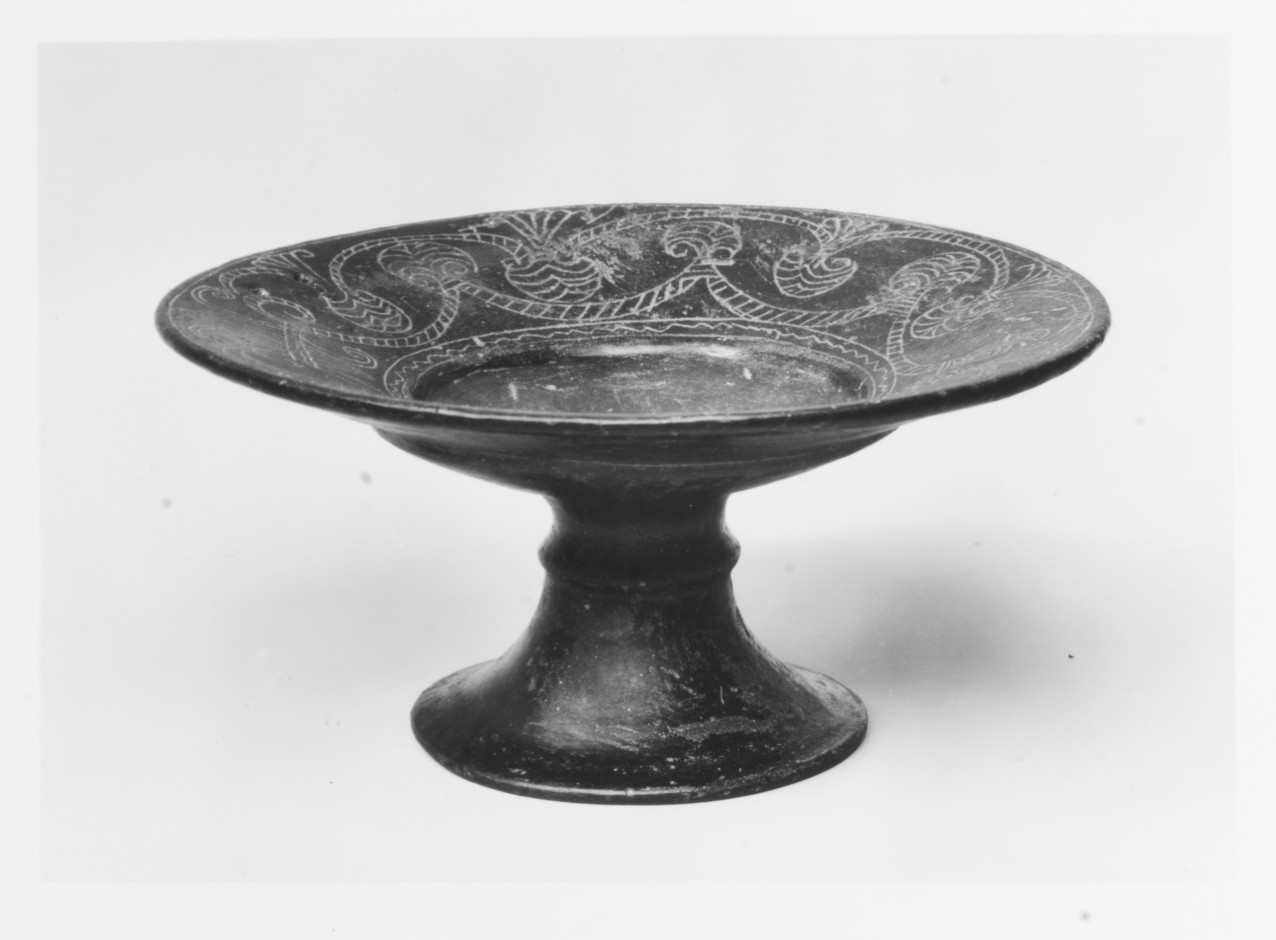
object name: plate, stemmed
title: Terracotta stemmed plate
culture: capenate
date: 625-600 BCE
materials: terracotta